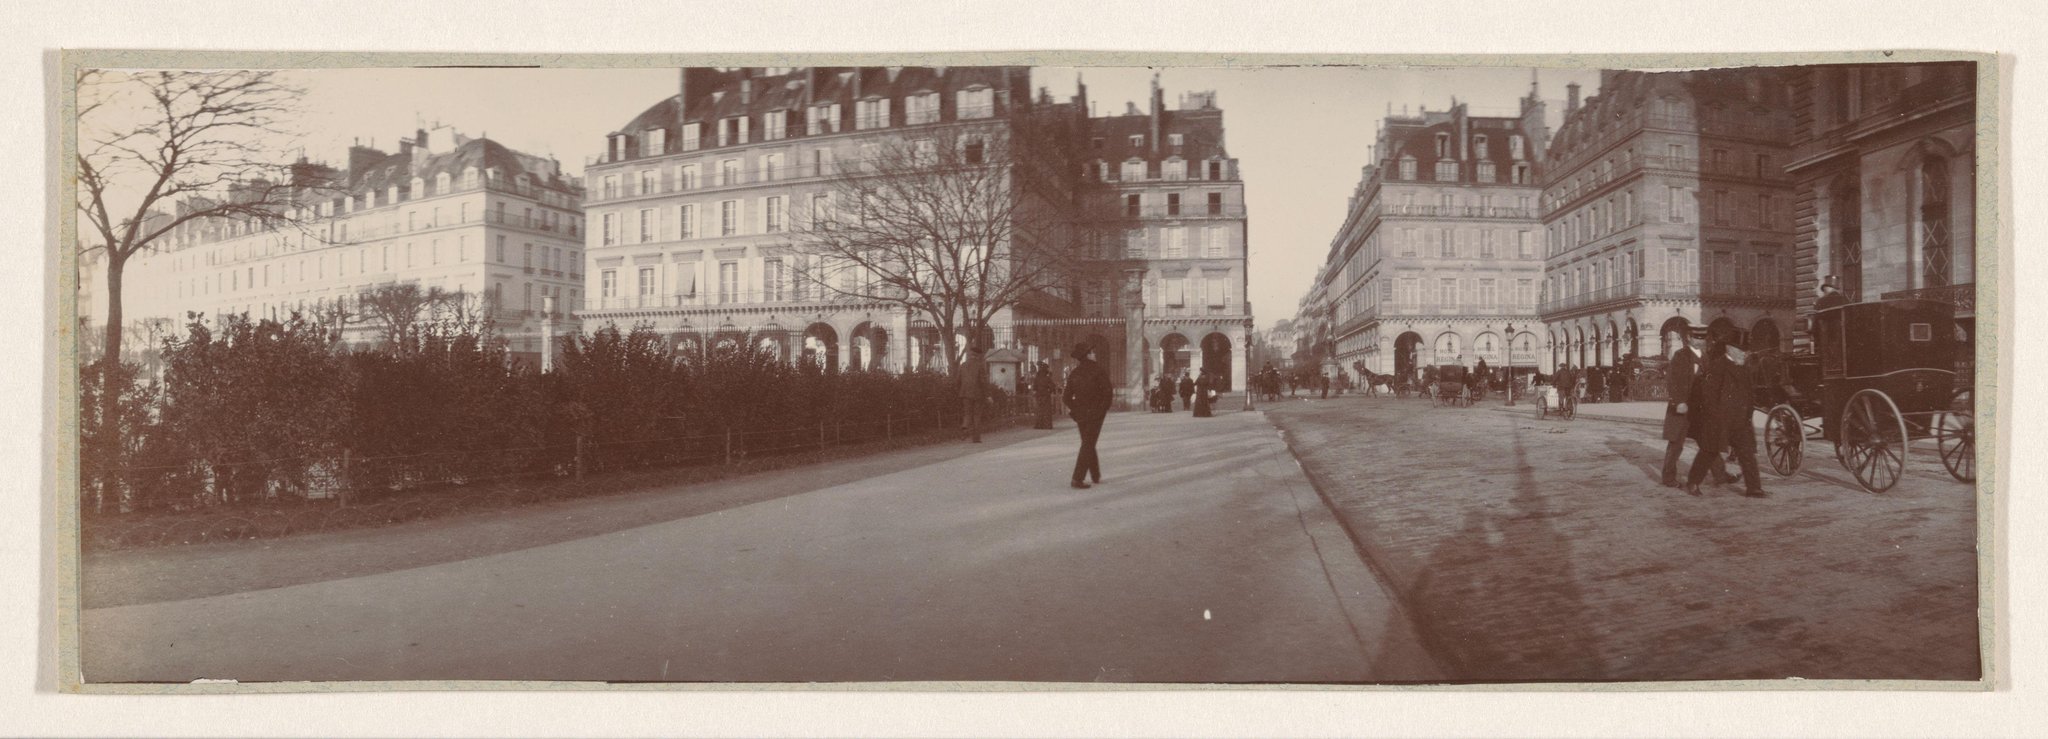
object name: panoramic photograph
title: Panorama van de Rue de Rivoli in Parijs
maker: Anonymous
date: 1900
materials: paper, cardboard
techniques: gelatin silver print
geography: paris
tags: city-view in general; 'veduta'